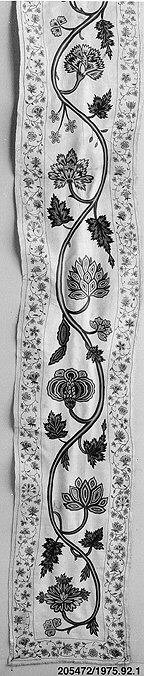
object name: border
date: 1701-1733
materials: cotton, silk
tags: flowers